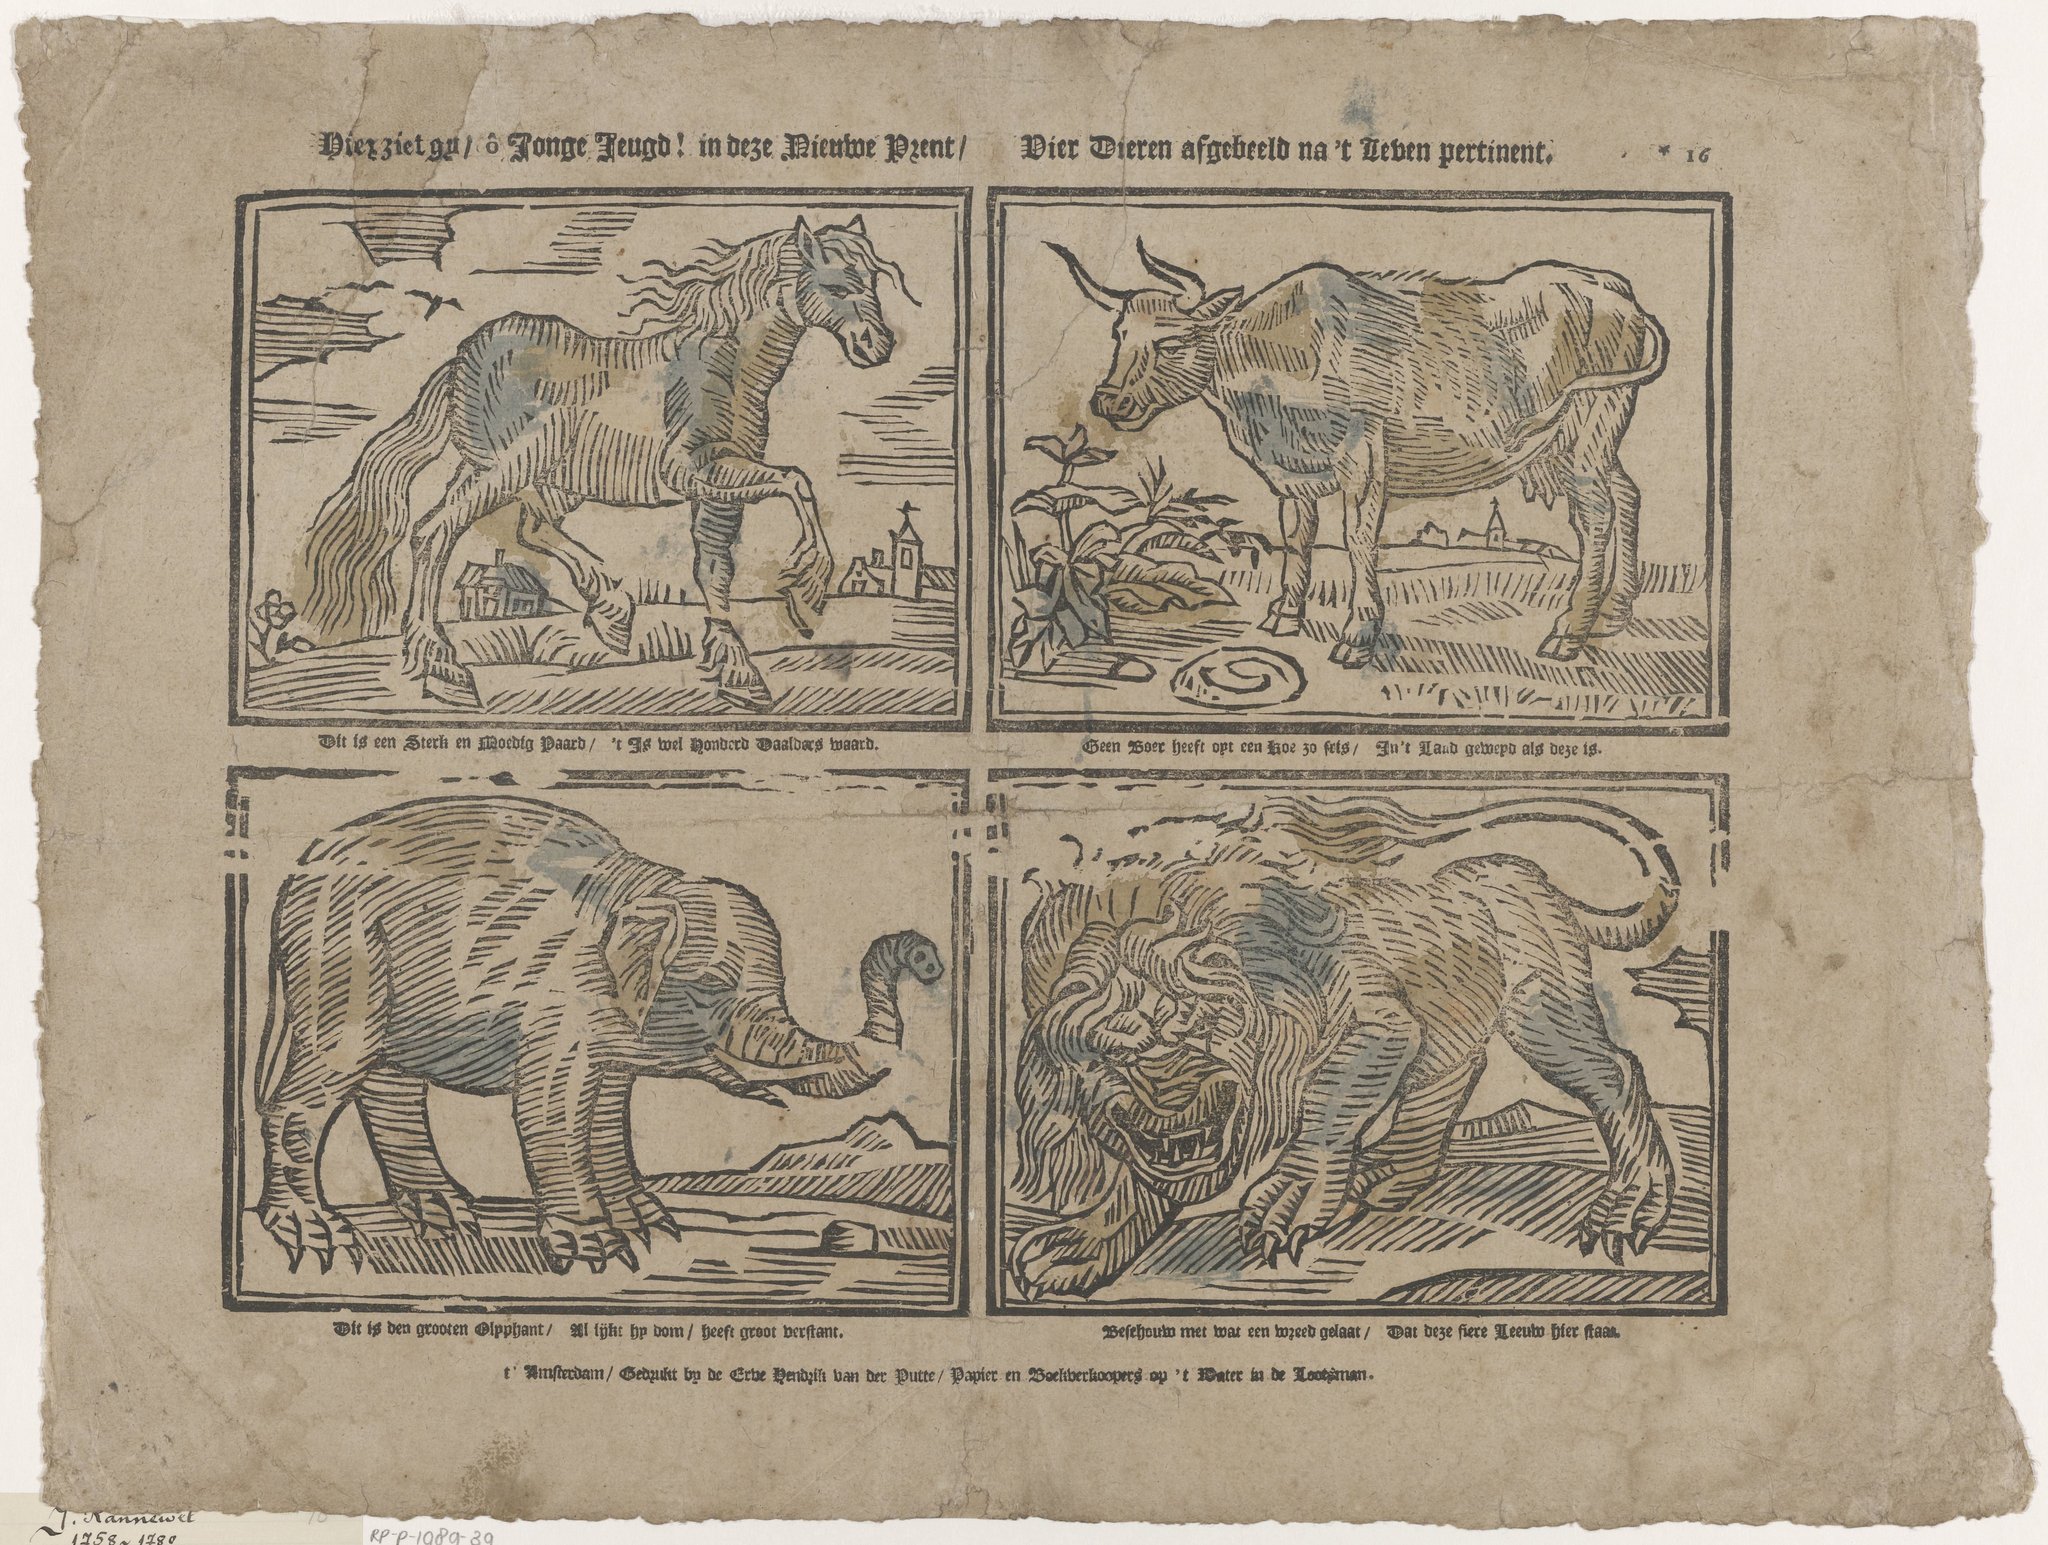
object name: popular print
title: Hier ziet gy / ô jonge jeugd! in deze nieuwe prent / Vier dieren afgebeeld na 't leven pertinent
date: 1767-1793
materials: paper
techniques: colour, letterpress printing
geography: netherlands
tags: cow, animals, horse, beasts of prey, predatory animals: lion, trunked animals: elephant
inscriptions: collector's mark: Lugt 2760, collector's mark: Lugt 2228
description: Blad met 4 voorstellingen van dieren: een paard, een koe, een olifant en een leeuw. Onder elke afbeelding een onderschrift. Genummerd rechtsboven: *16.